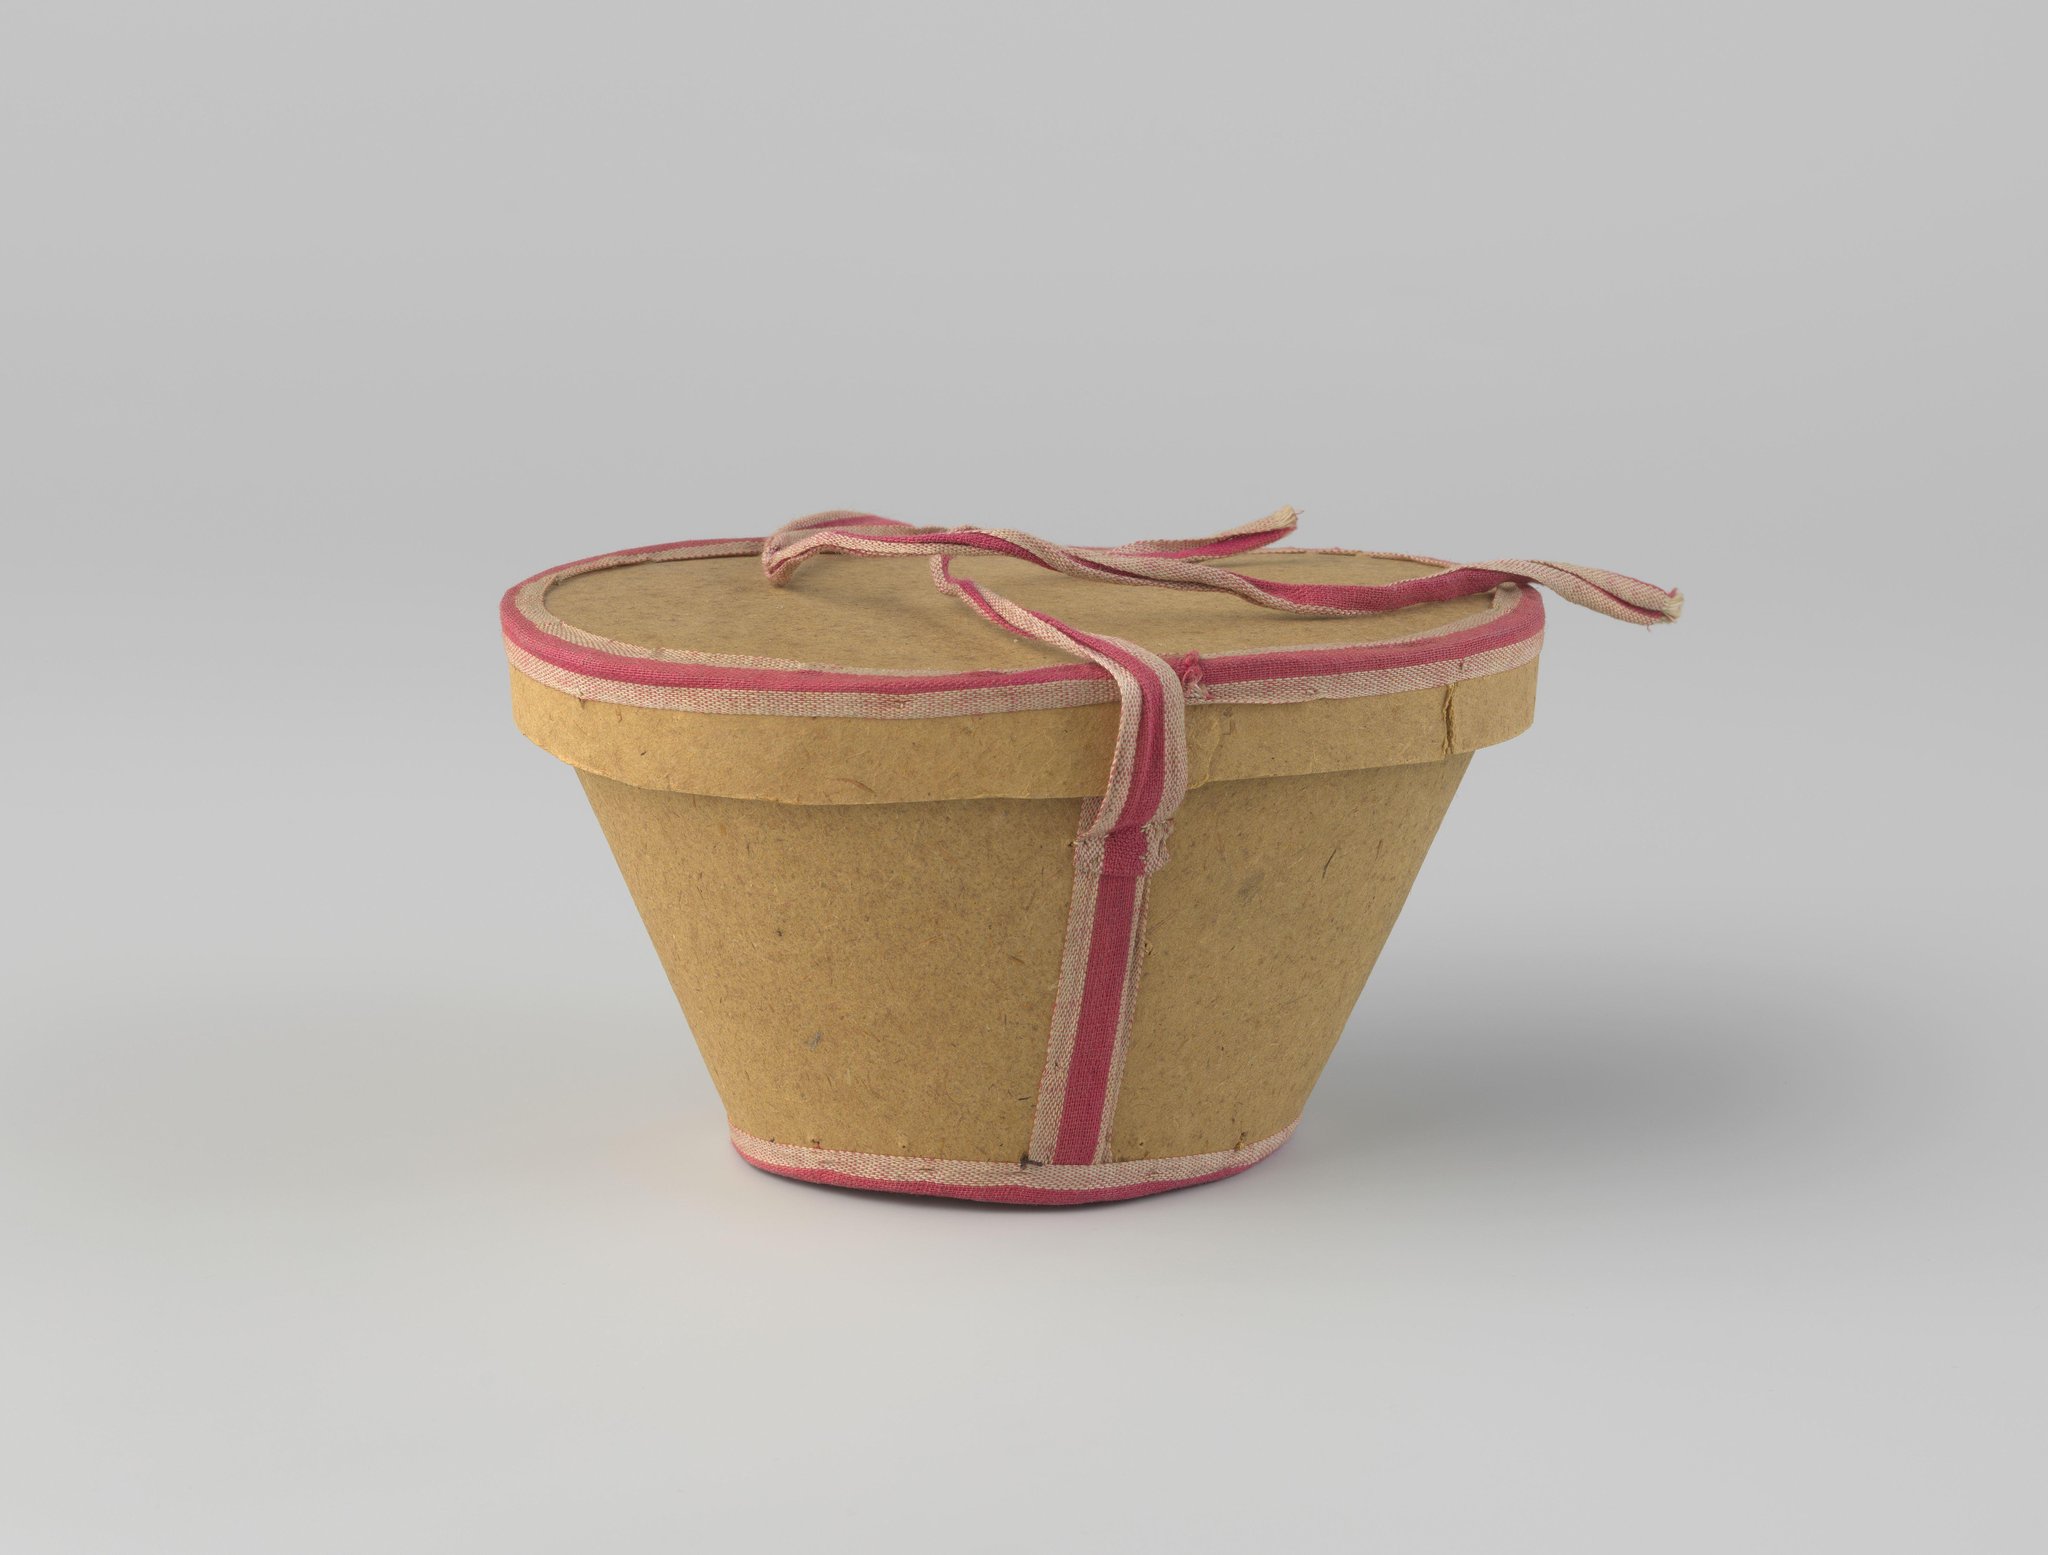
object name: hat box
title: Hoedendoos van een miniatuur hoge hoed, van onbeplakt houtkleurig karton; de naden zijn met een wit- en cérisekleurig bandje verstevigd, waarmee het ook gesloten wordt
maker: Anonymous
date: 1901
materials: cardboard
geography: england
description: Hoedendoos van een miniatuur hoge hoed, van onbeplakt houtkleurig karton; de naden zijn met een wit- en cérisekleurig bandje verstevigd, waarmee het ook gesloten wordt.